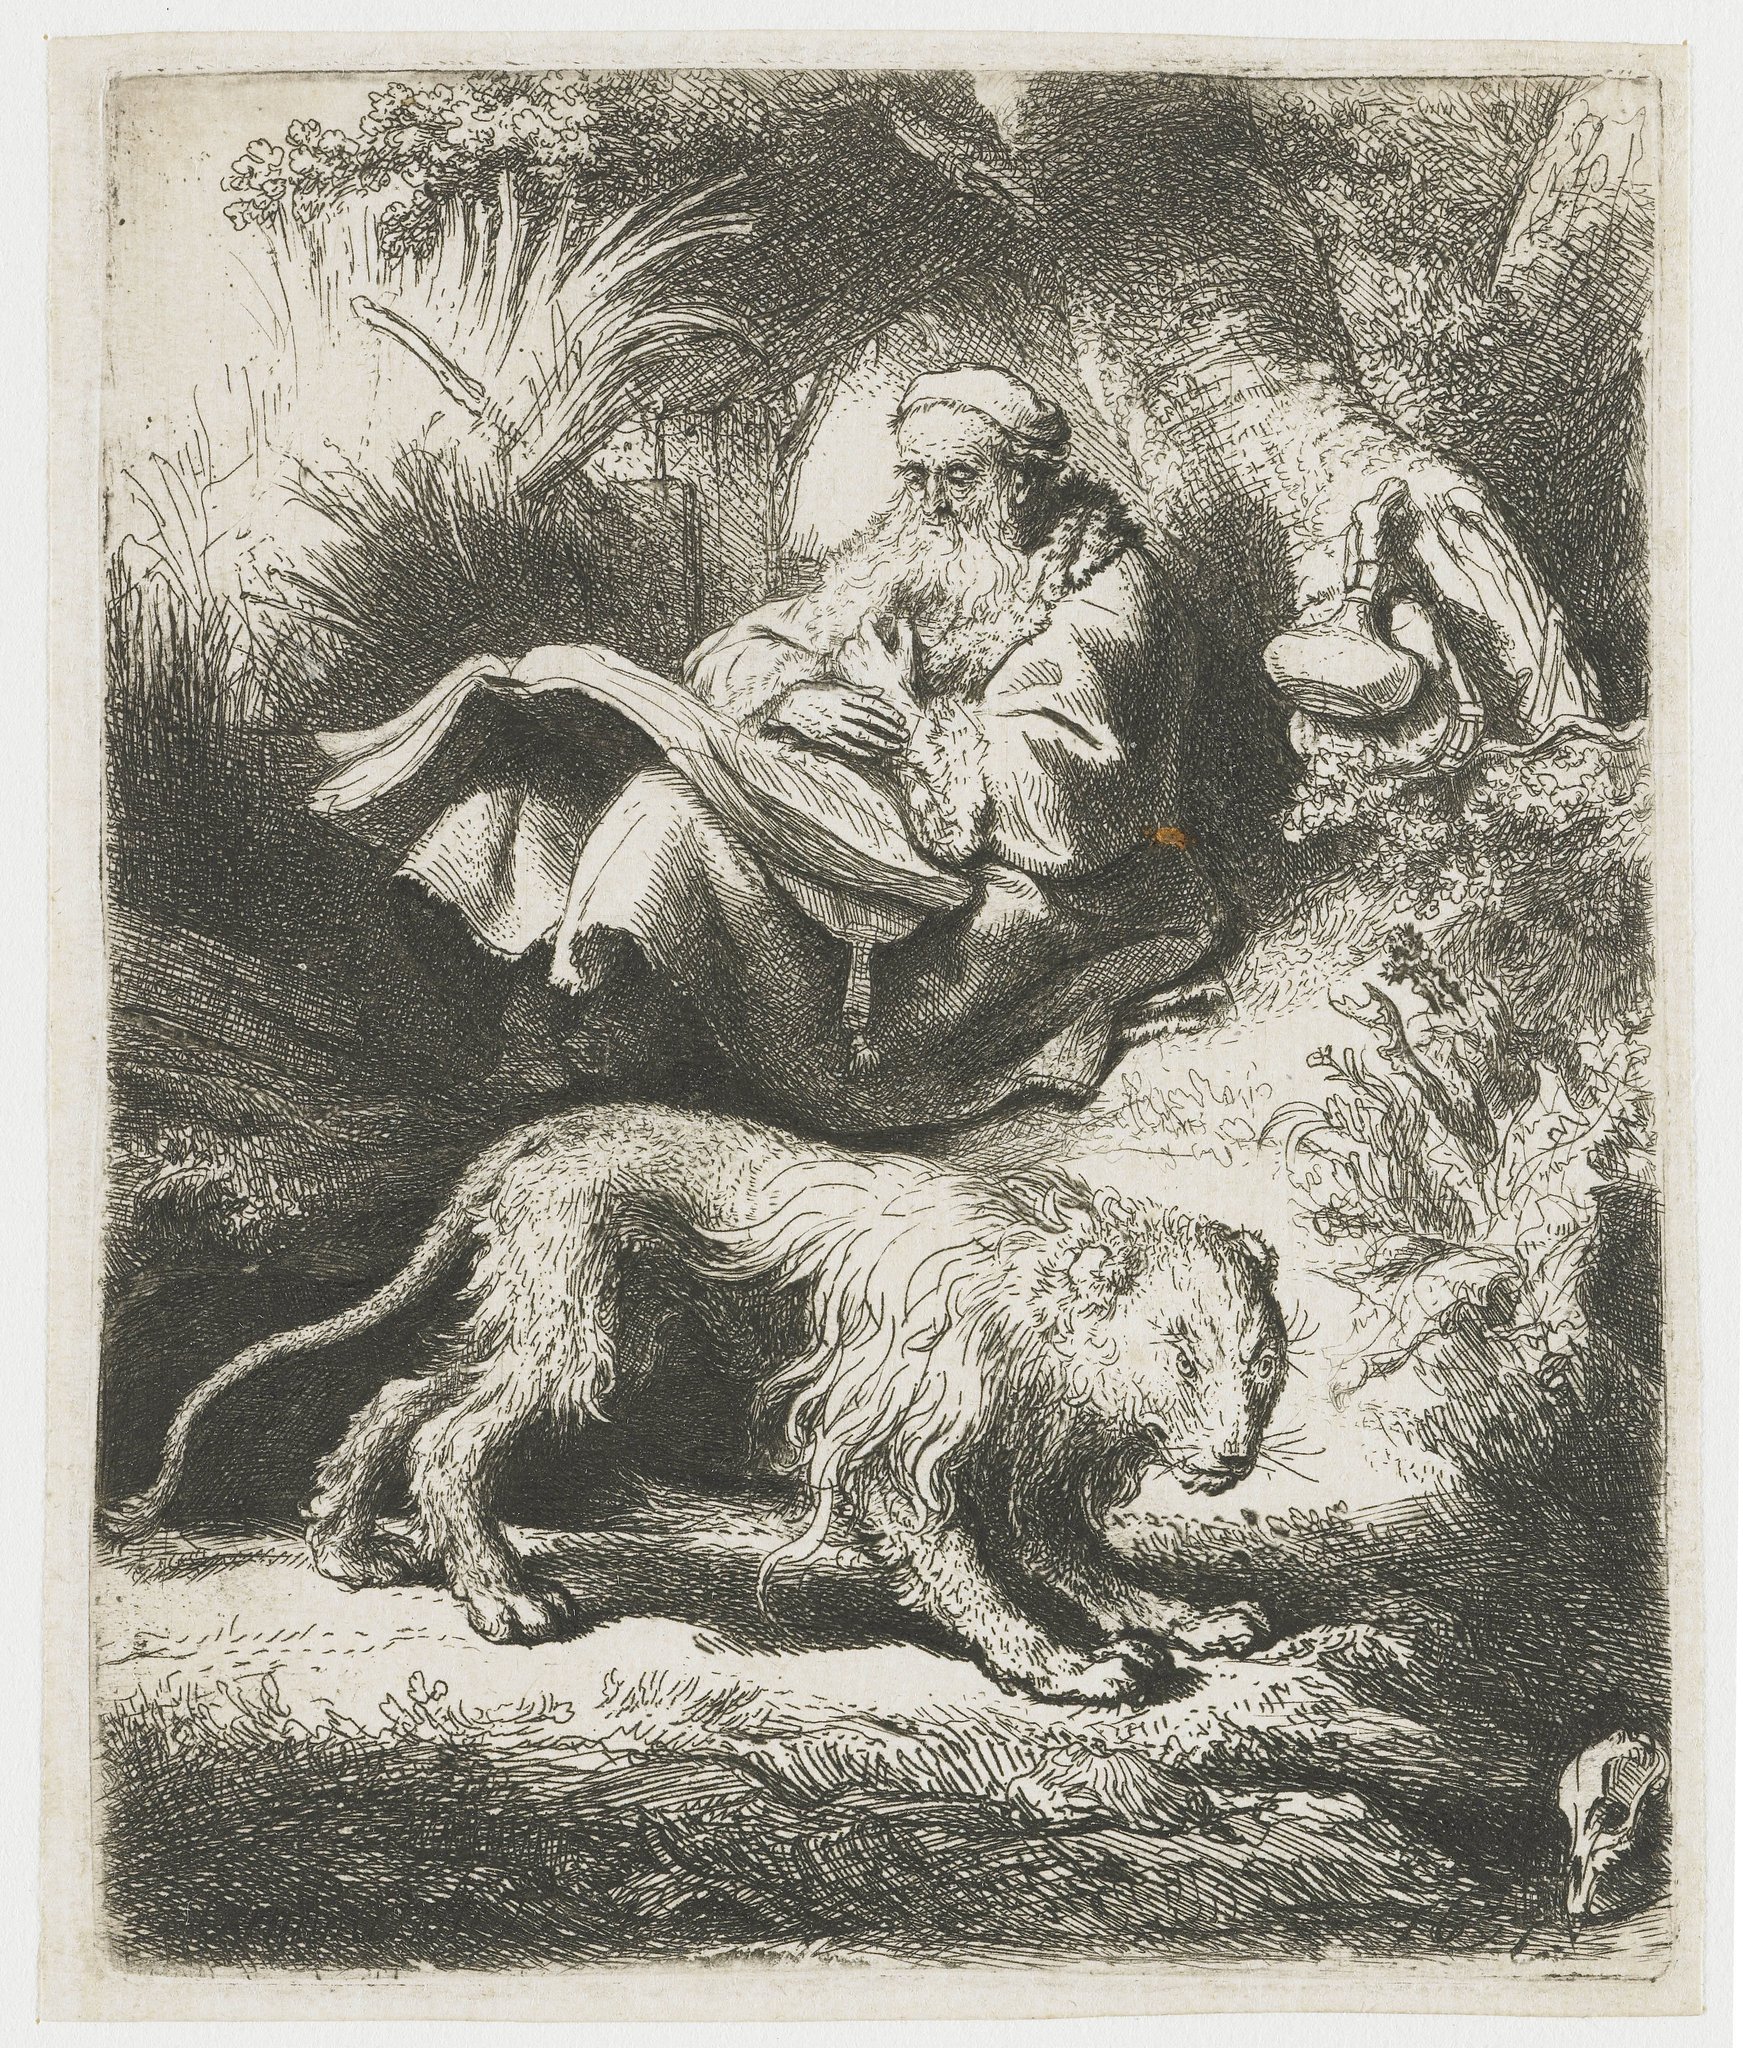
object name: print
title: St Jerome reading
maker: rembrandt van rijn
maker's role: draughtsman, painter, print maker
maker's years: 1606-1669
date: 1634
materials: paper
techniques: etching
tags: st. jerome as hermit in a landscape, reading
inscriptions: collector's mark: Lugt 2228, date: ‘1634’, signature: ‘Rembrandt f.’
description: St Jerome once helped a lion by removing a painful thorn from its paw, and is thus often depicted together with the animal. Here the creature looks like a strapping, misshapen cat, undoubtedly because Rembrandt at this point had never seen a real lion. He probably based his representation on (equally awkward) models in 16th-century prints.